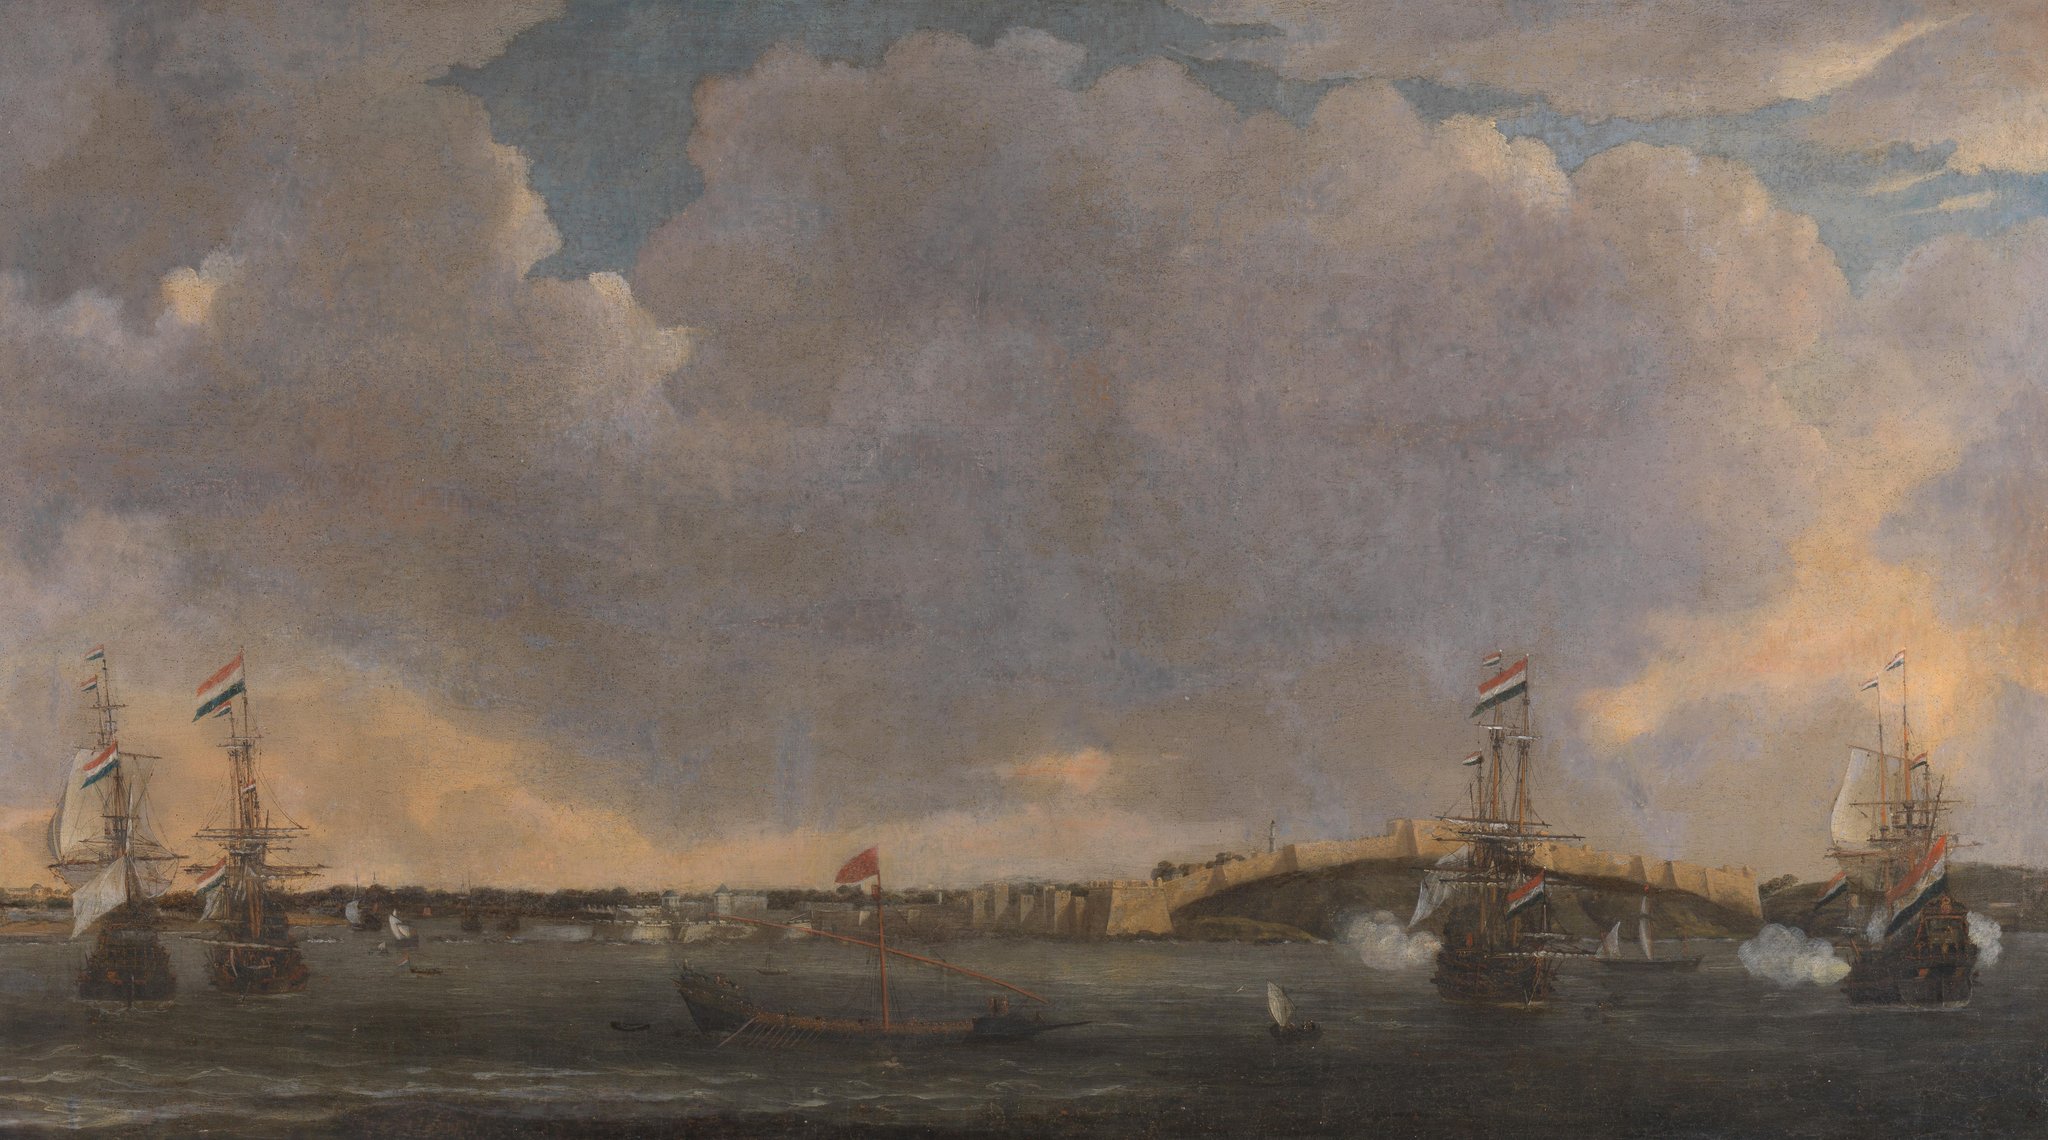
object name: painting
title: View of Tripoli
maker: reinier nooms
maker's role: draughtsman, painter, print maker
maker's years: 1623-1664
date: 1662-1668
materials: canvas, oil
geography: amsterdam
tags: sailing-ship, sailing-boat, coast, trireme, galley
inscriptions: signature, on a flag: ‘R. Zeeman’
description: Four views of North-African cities. Reinier Nooms, c. 1665. To protect the Dutch merchant fleet, the navy took the fight the enemy, far beyond the country's coastal waters. The Mediterranean harbours shown here - Algiers, Tunis, Tripoli and Salee - were bases from which privateers attacked Dutch merchant shipping. Attempts were made to impose treaties on these cities using the threat of naval force. Between 1661 and 1663 Admiral Michiel de Ruyter cruised the Mediterranean Sea in an effort to stamp out piracy. De Ruyter's ship, de Liefde, is shown in the foreground of the view of Algiers. This series of paintings was displayed in one of the rooms of the Amsterdam Admiralty. The Republic's navy was divided into five regional admiralties, one of which was based in Amsterdam.